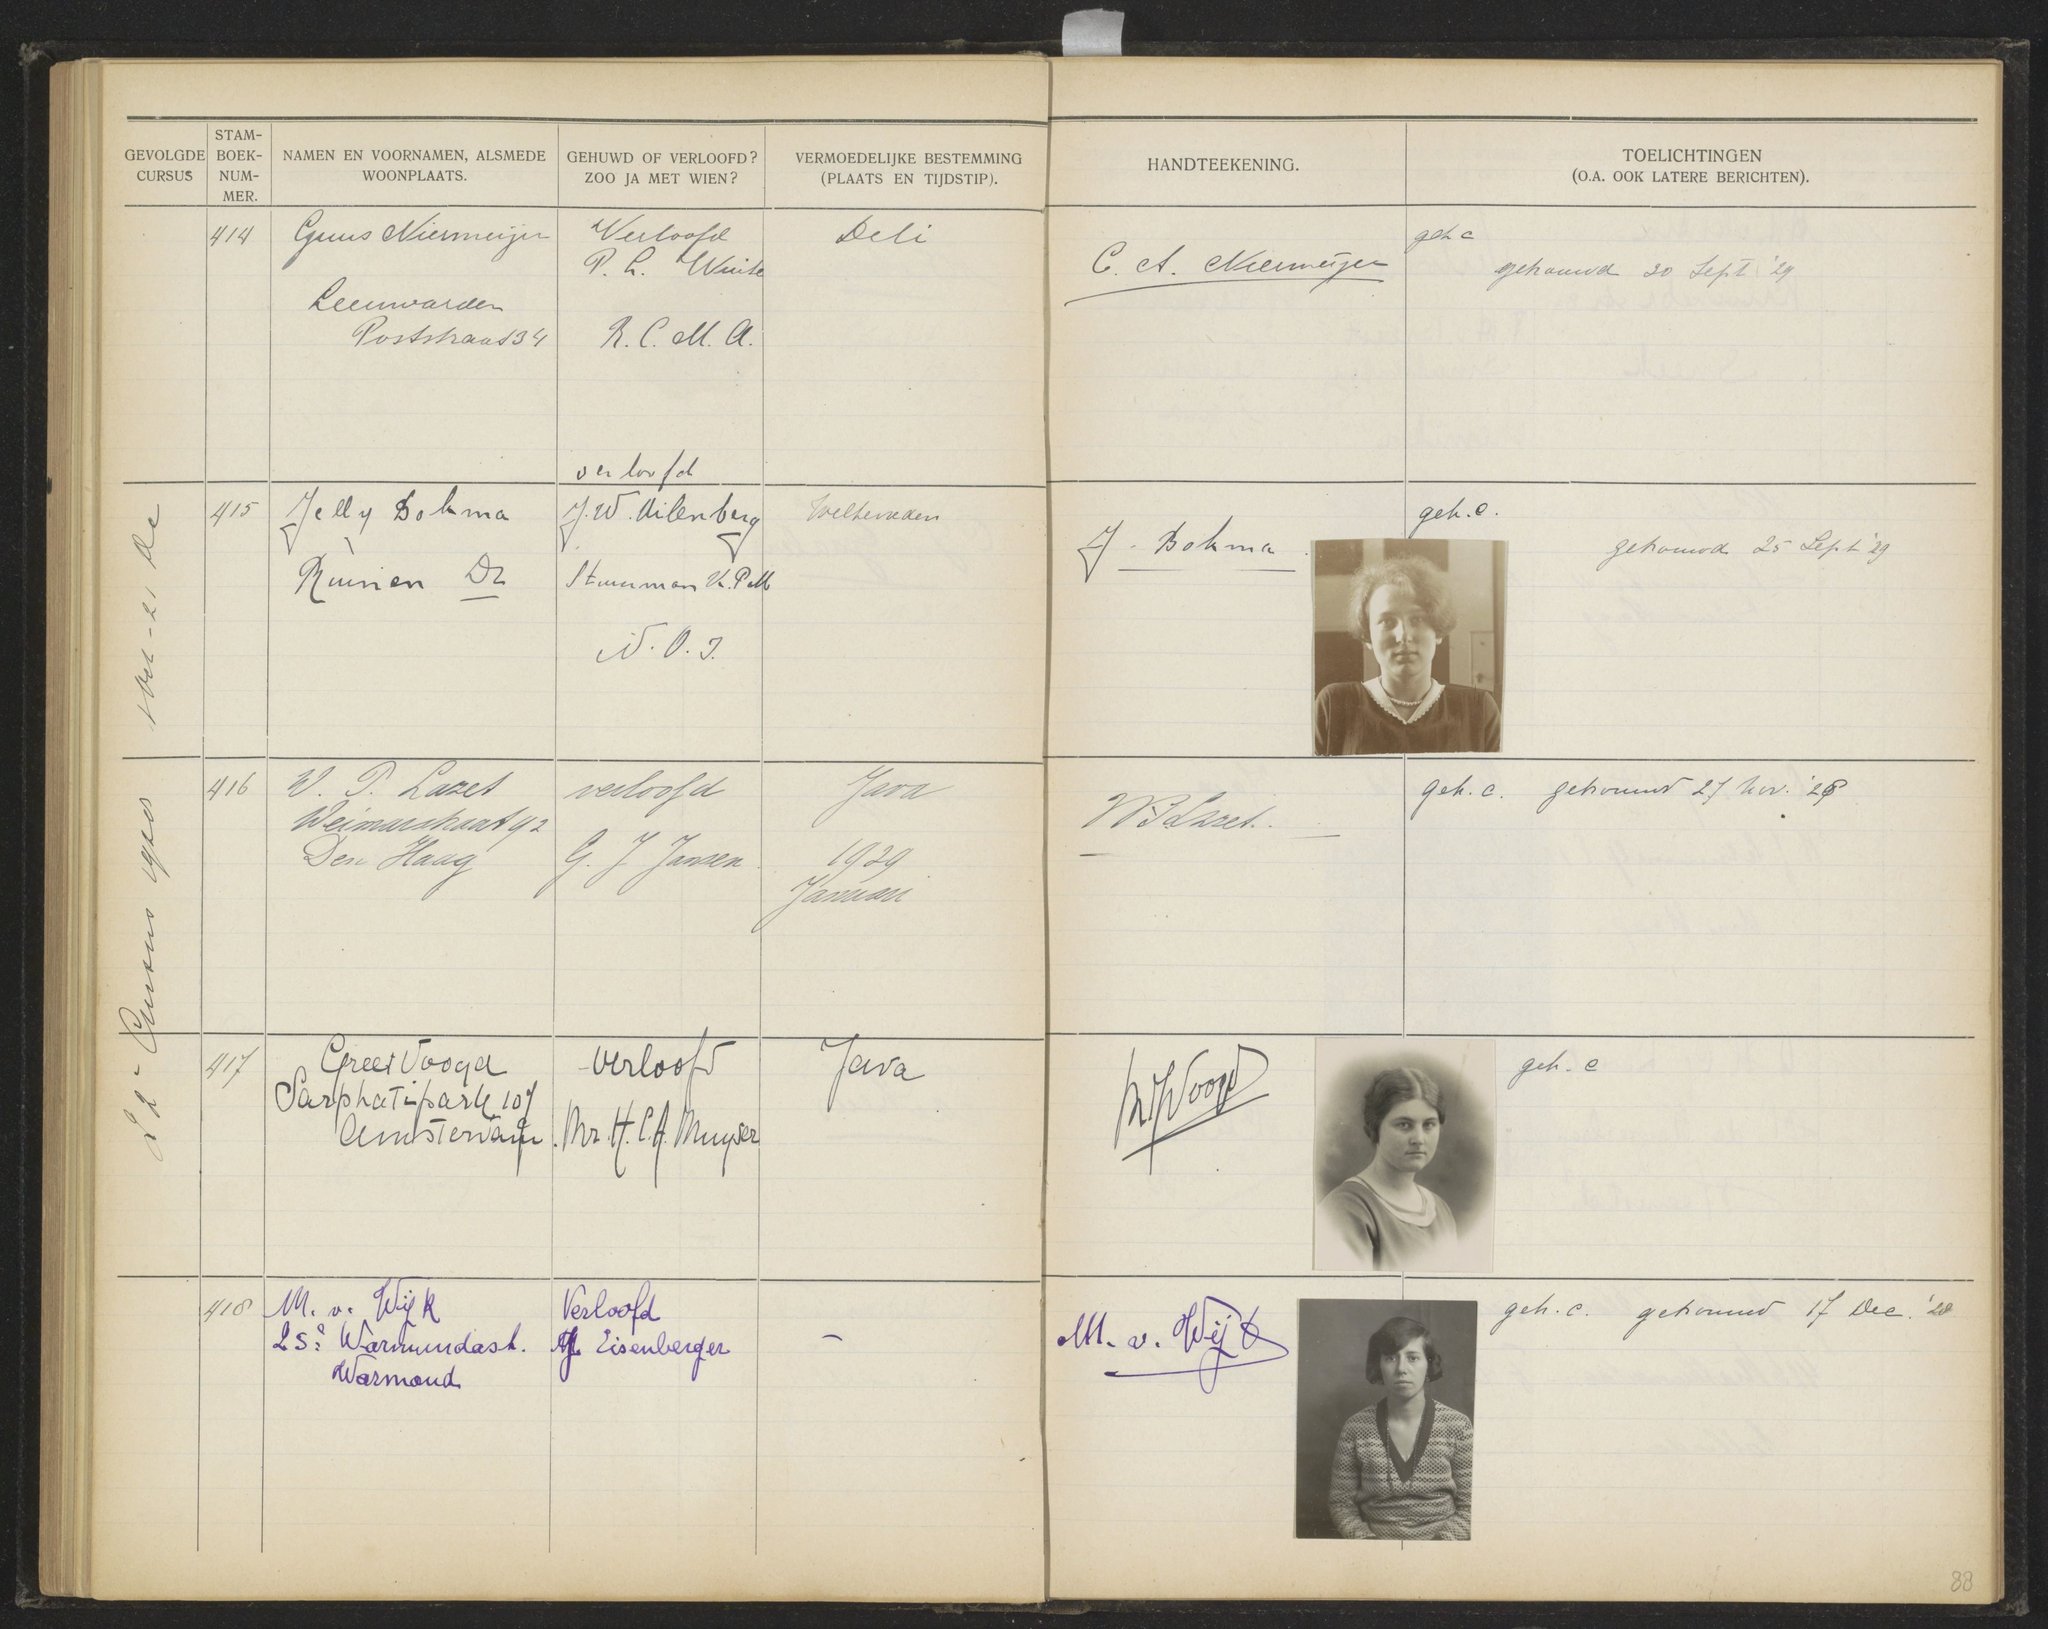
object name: photograph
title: Blad 88 uit Stamboek van de leerlingen der Koloniale School voor Meisjes en Vrouwen te 's-Gravenhage deel I (1921-1929)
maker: Anonymous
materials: paper, photographic support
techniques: photography, printing, writing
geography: the hague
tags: further education (+ pupil), further education, the hague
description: Twee pagina's met gegevens van de deelnemers aan de 22e driemaandelijkse cursus van 1 oktober tot en met 21 december 1928, stamboeknummers 414 tot en met 418. Onderdeel van Stamboek van de leerlingen der Koloniale School voor Meisjes en Vrouwen te 's-Gravenhage deel I (1921-1929).